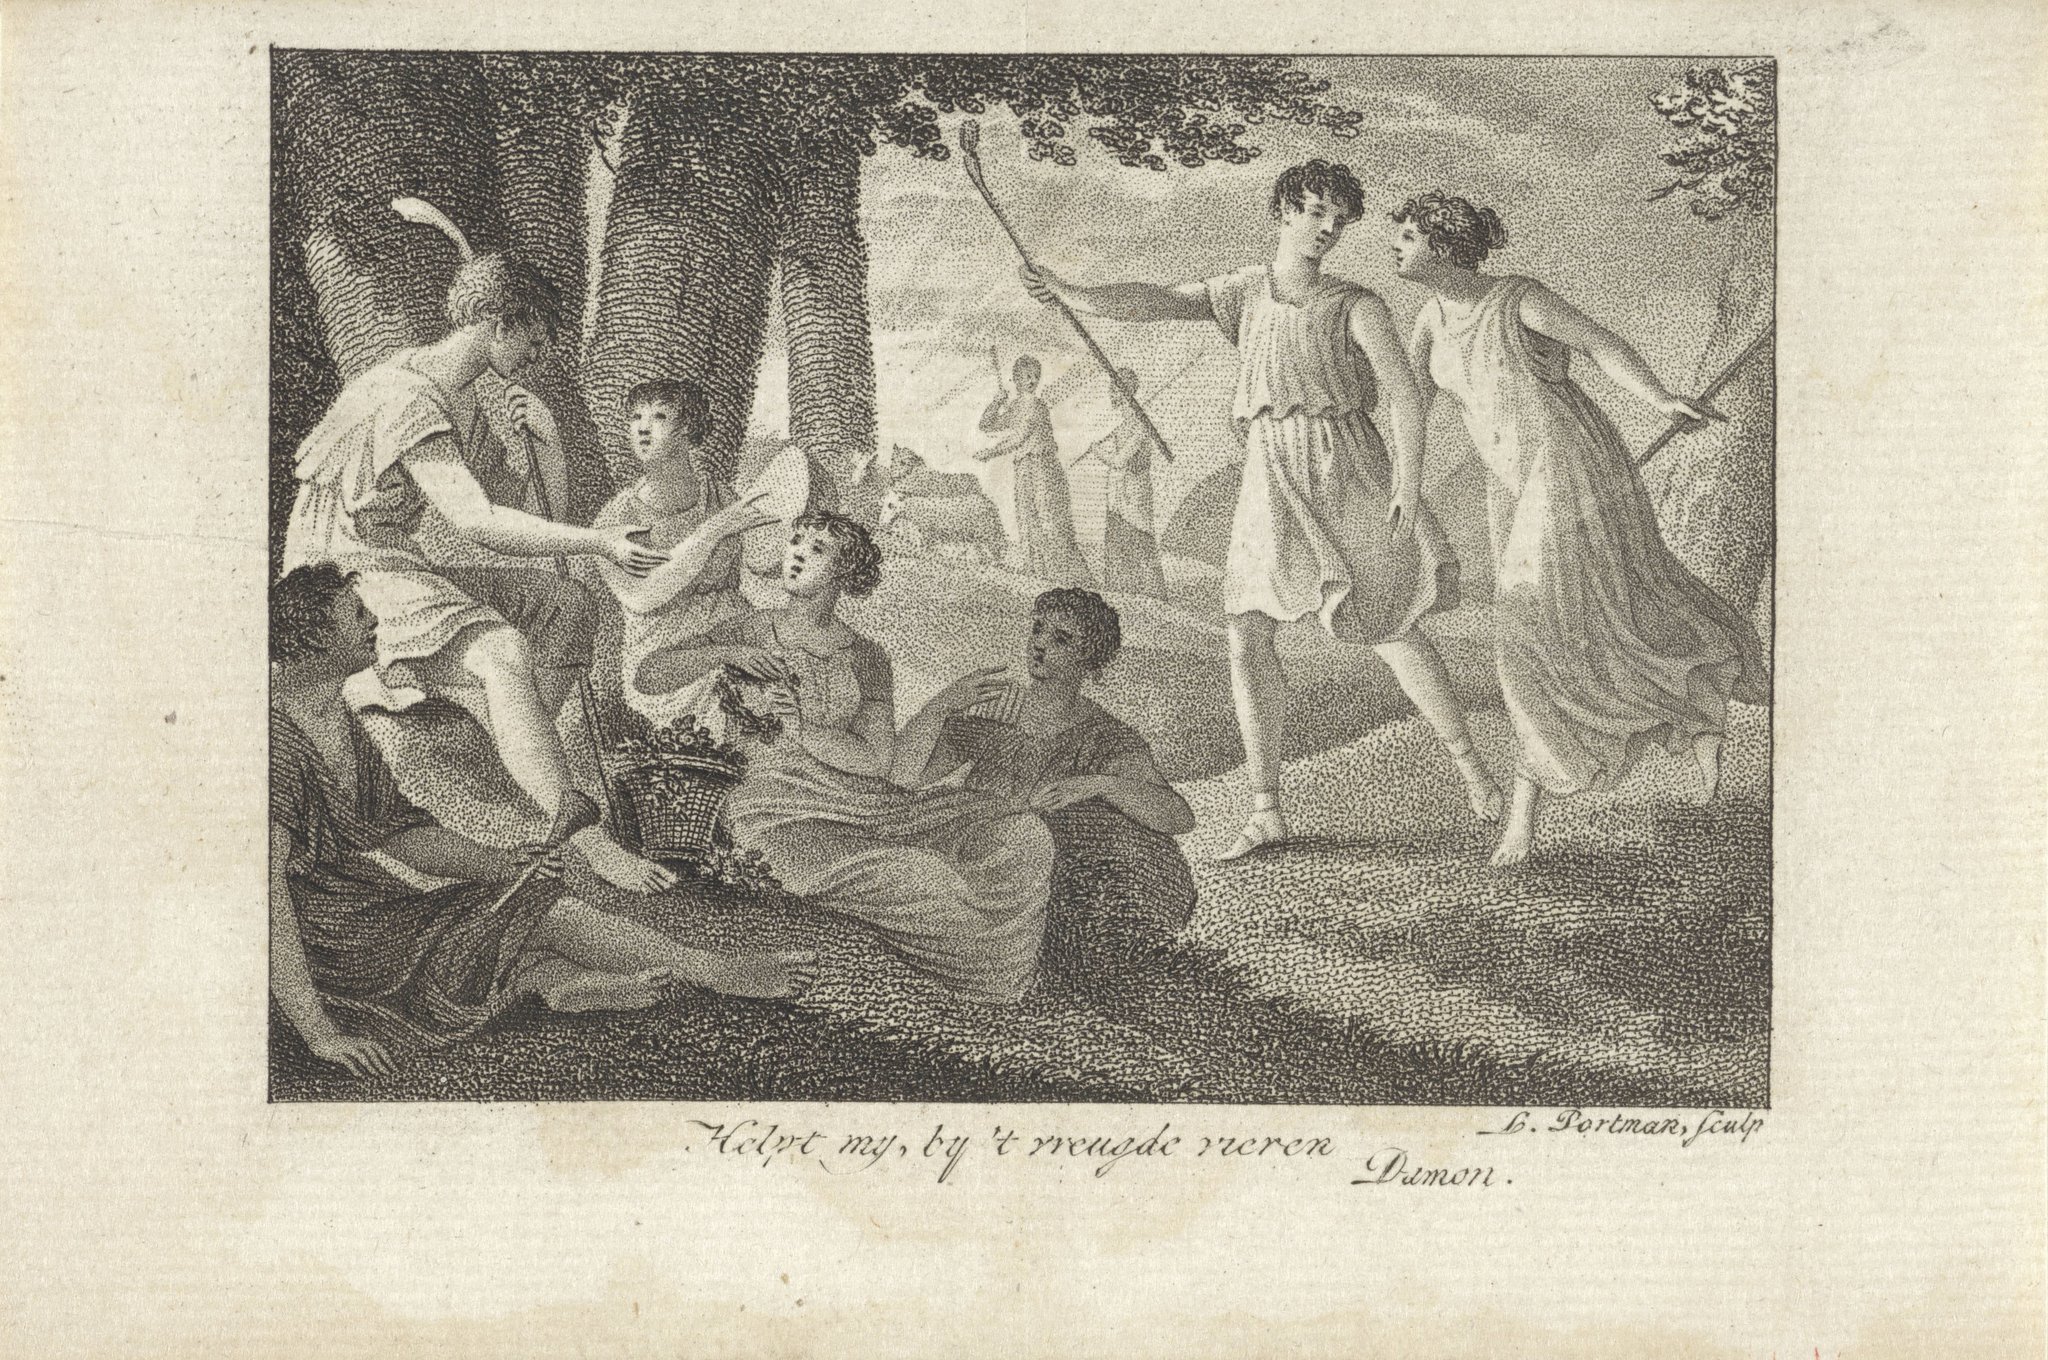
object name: book illustration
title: Landschap met herders en herderinnen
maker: ludwig gottlieb portman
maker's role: print maker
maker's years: 1772-1828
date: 1803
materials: paper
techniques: etching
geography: amsterdam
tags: herding, herdsman, herdswoman, shepherd, shepherdess, cowherd, etc., specific works of literature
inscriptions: collector's mark: Lugt 2228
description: Op een heuvel in het bos zit een herder te midden van herderinnen. Een paar loopt hand in hand naar de groep toe. Illustratie van een scène uit 'Damon op het huwelijk van Daphnis en Phyllis'.